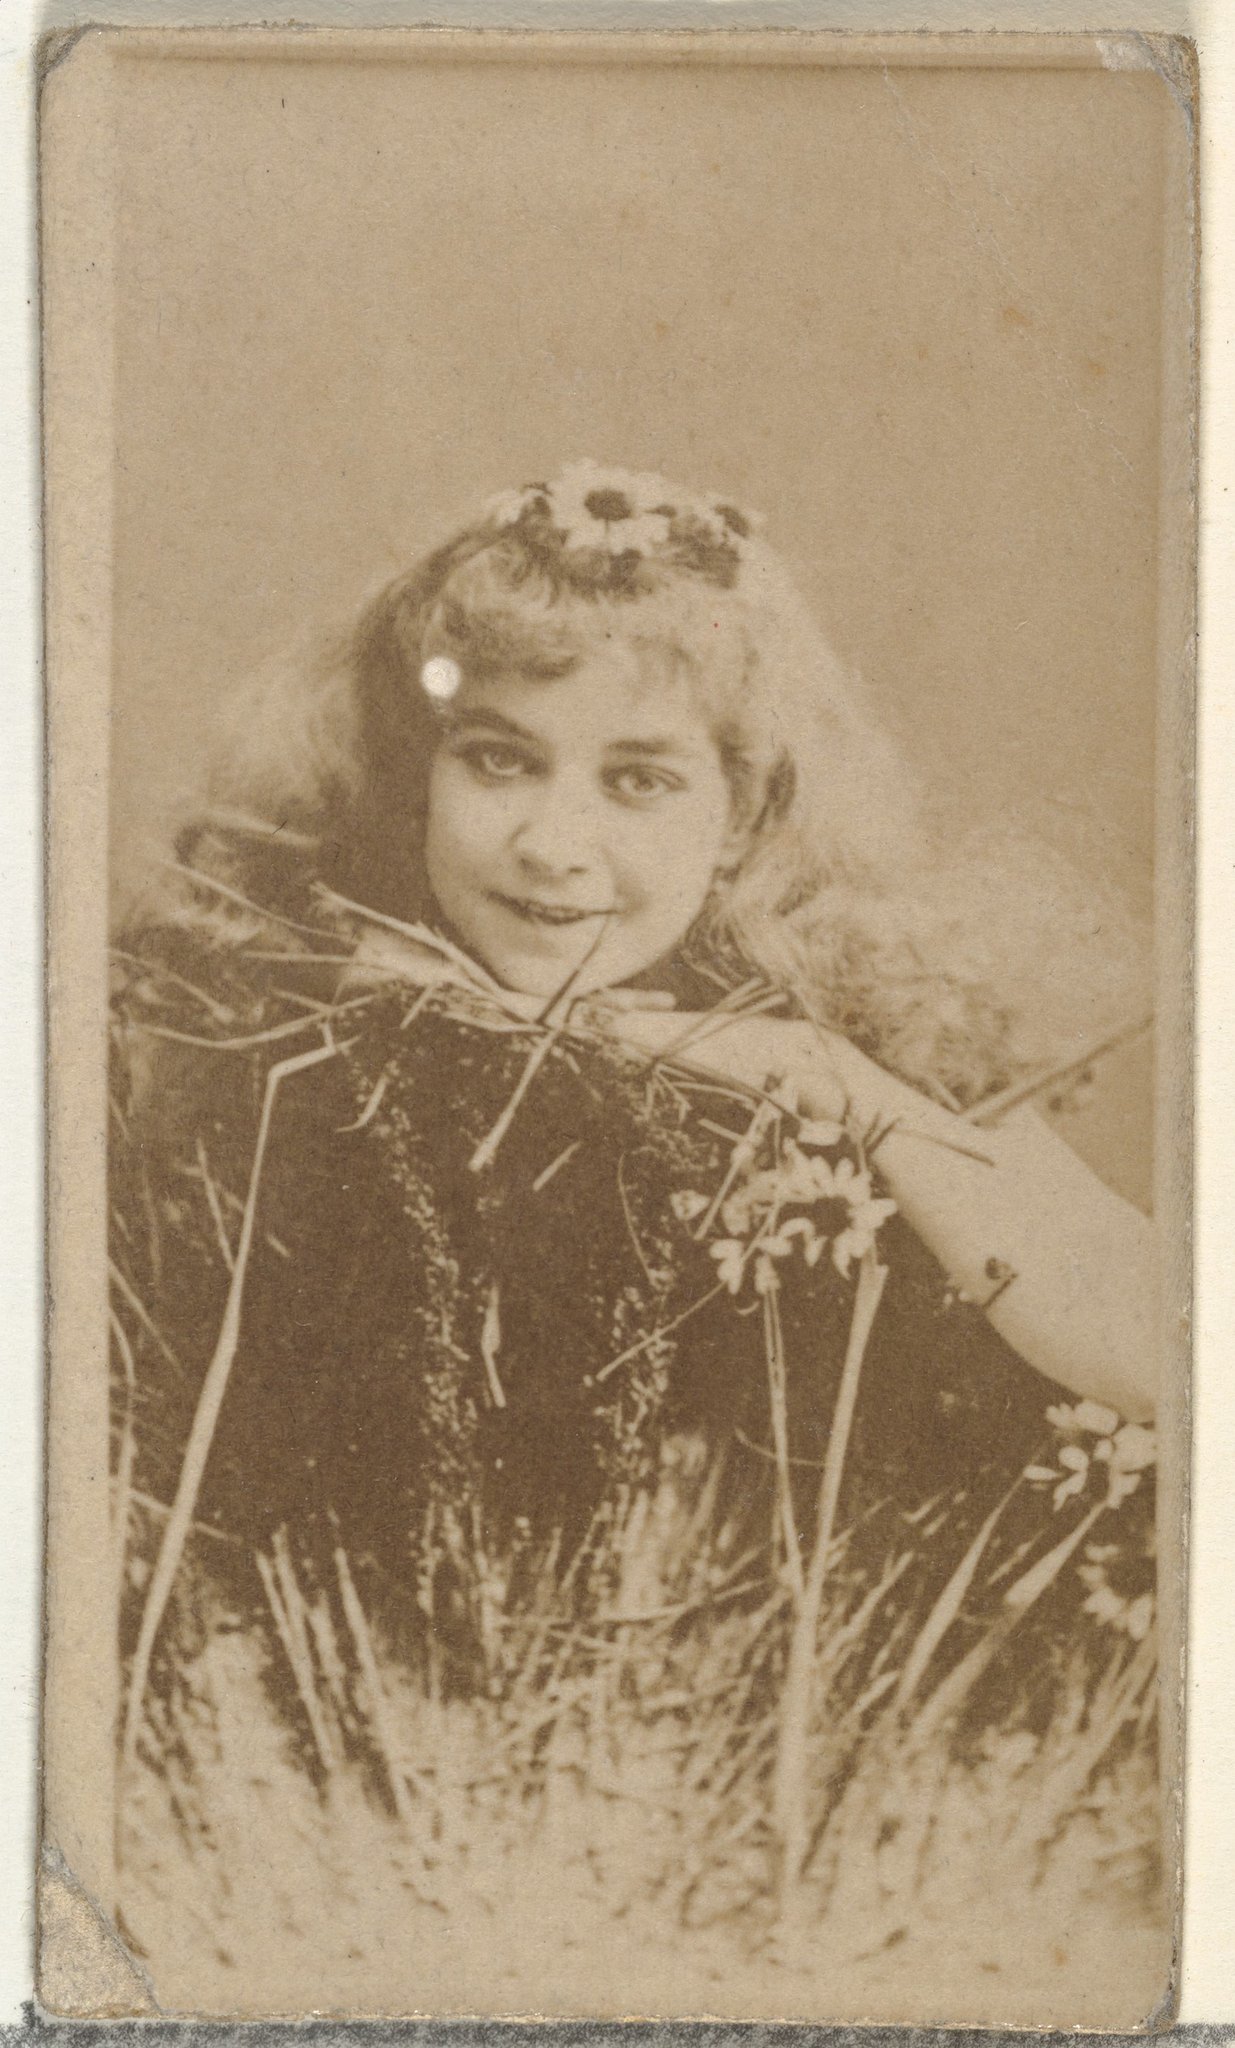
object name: photograph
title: [Actress posing in grass with daisy in hair], from the Actors and Actresses series (N145-8) issued by Duke Sons & Co. to promote Duke Cigarettes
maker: w. duke, sons & co.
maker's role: publisher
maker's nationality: american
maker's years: 1870-1920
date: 1891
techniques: albumen silver print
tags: portraits,women,actresses